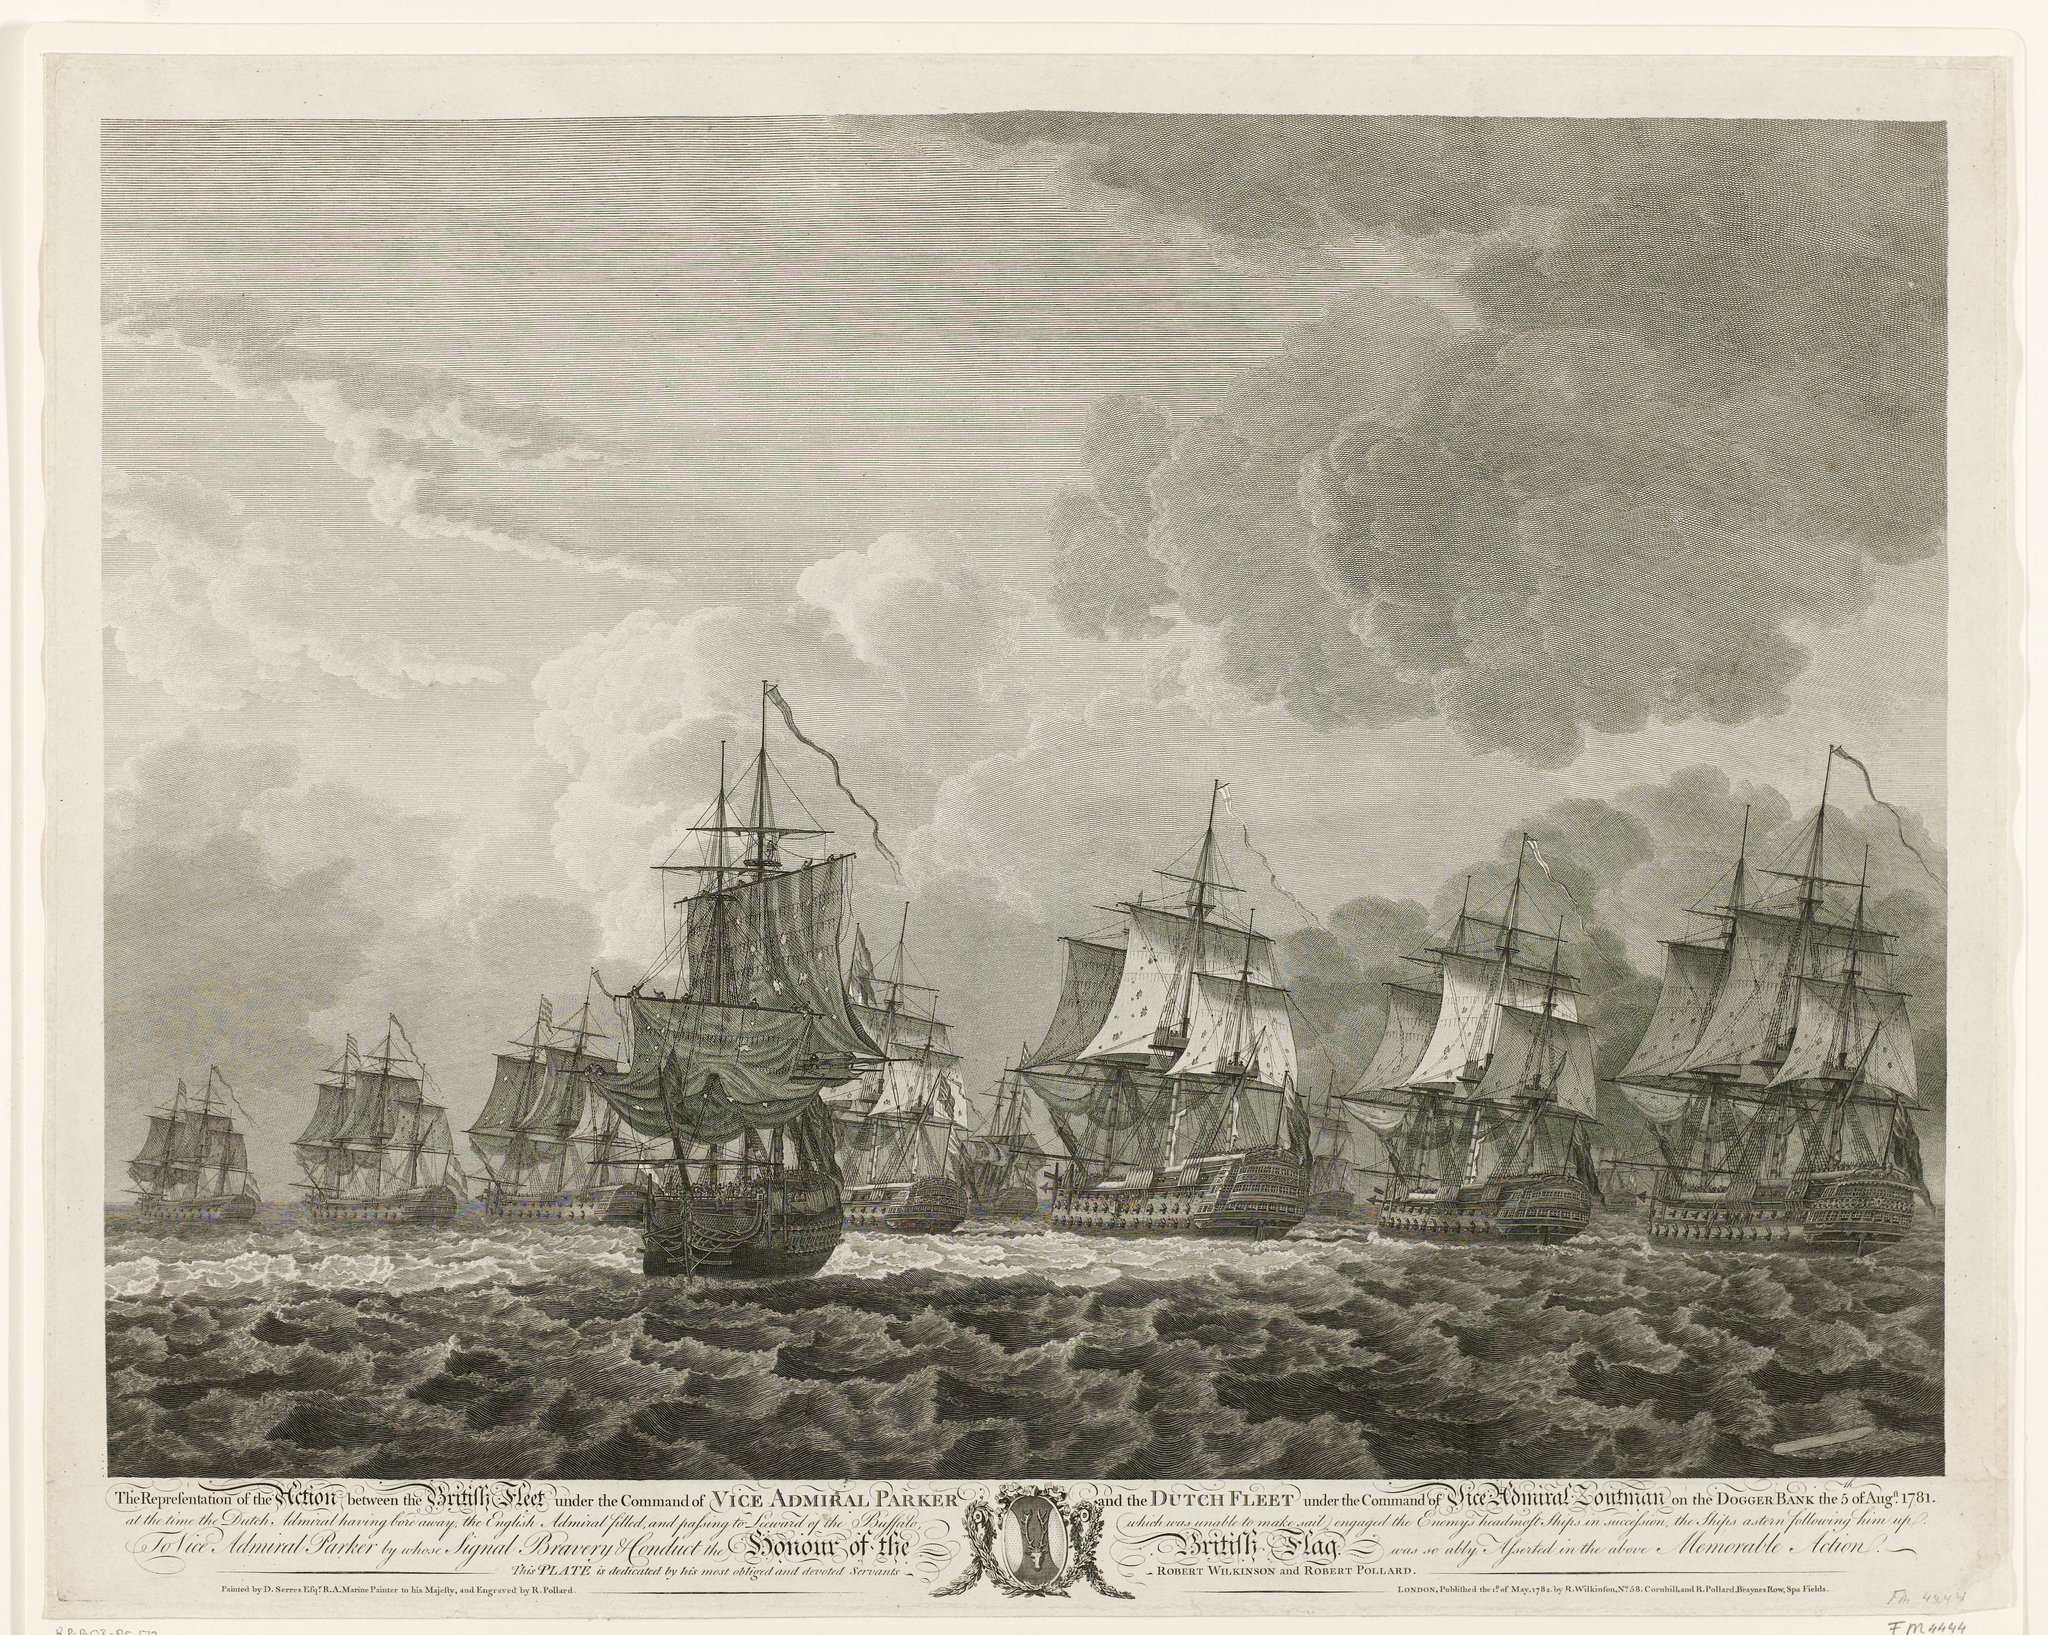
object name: print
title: Zeeslag bij Doggersbank, 1781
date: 1782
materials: paper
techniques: engraving, etching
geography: england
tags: the hague, johan arnold zoutman, hyde parker, battle (+ naval force)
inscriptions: collector's mark: Lugt 2228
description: De Nederlandse en Engelse schepen tijdens de zeeslag bij Doggersbank op 5 augustus 1781 tussen de Nederlandse vloot onder schout-bij-nacht Johan Zoutman en de Engelse vloot onder vice-admiraal Hyde Parker. In het onderschrift in het midden een wapen met bloemenkrans en de opdracht aan Parker